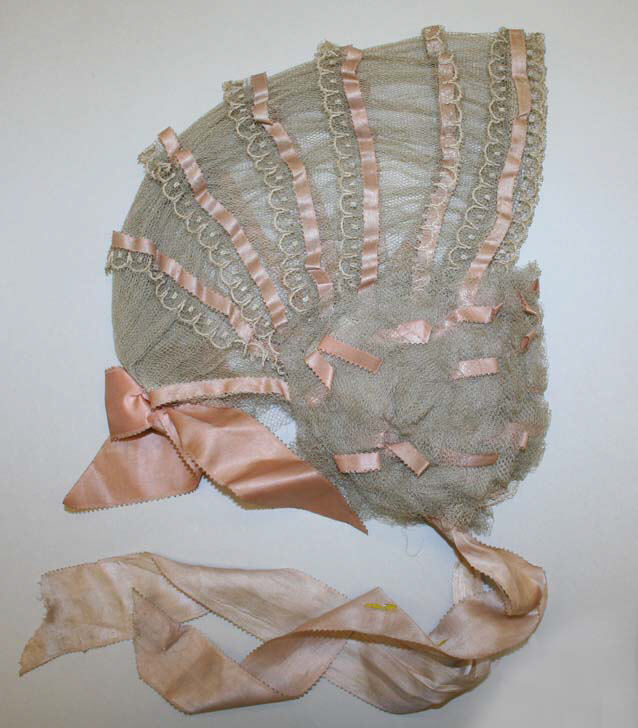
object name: bonnet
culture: british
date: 1850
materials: silk